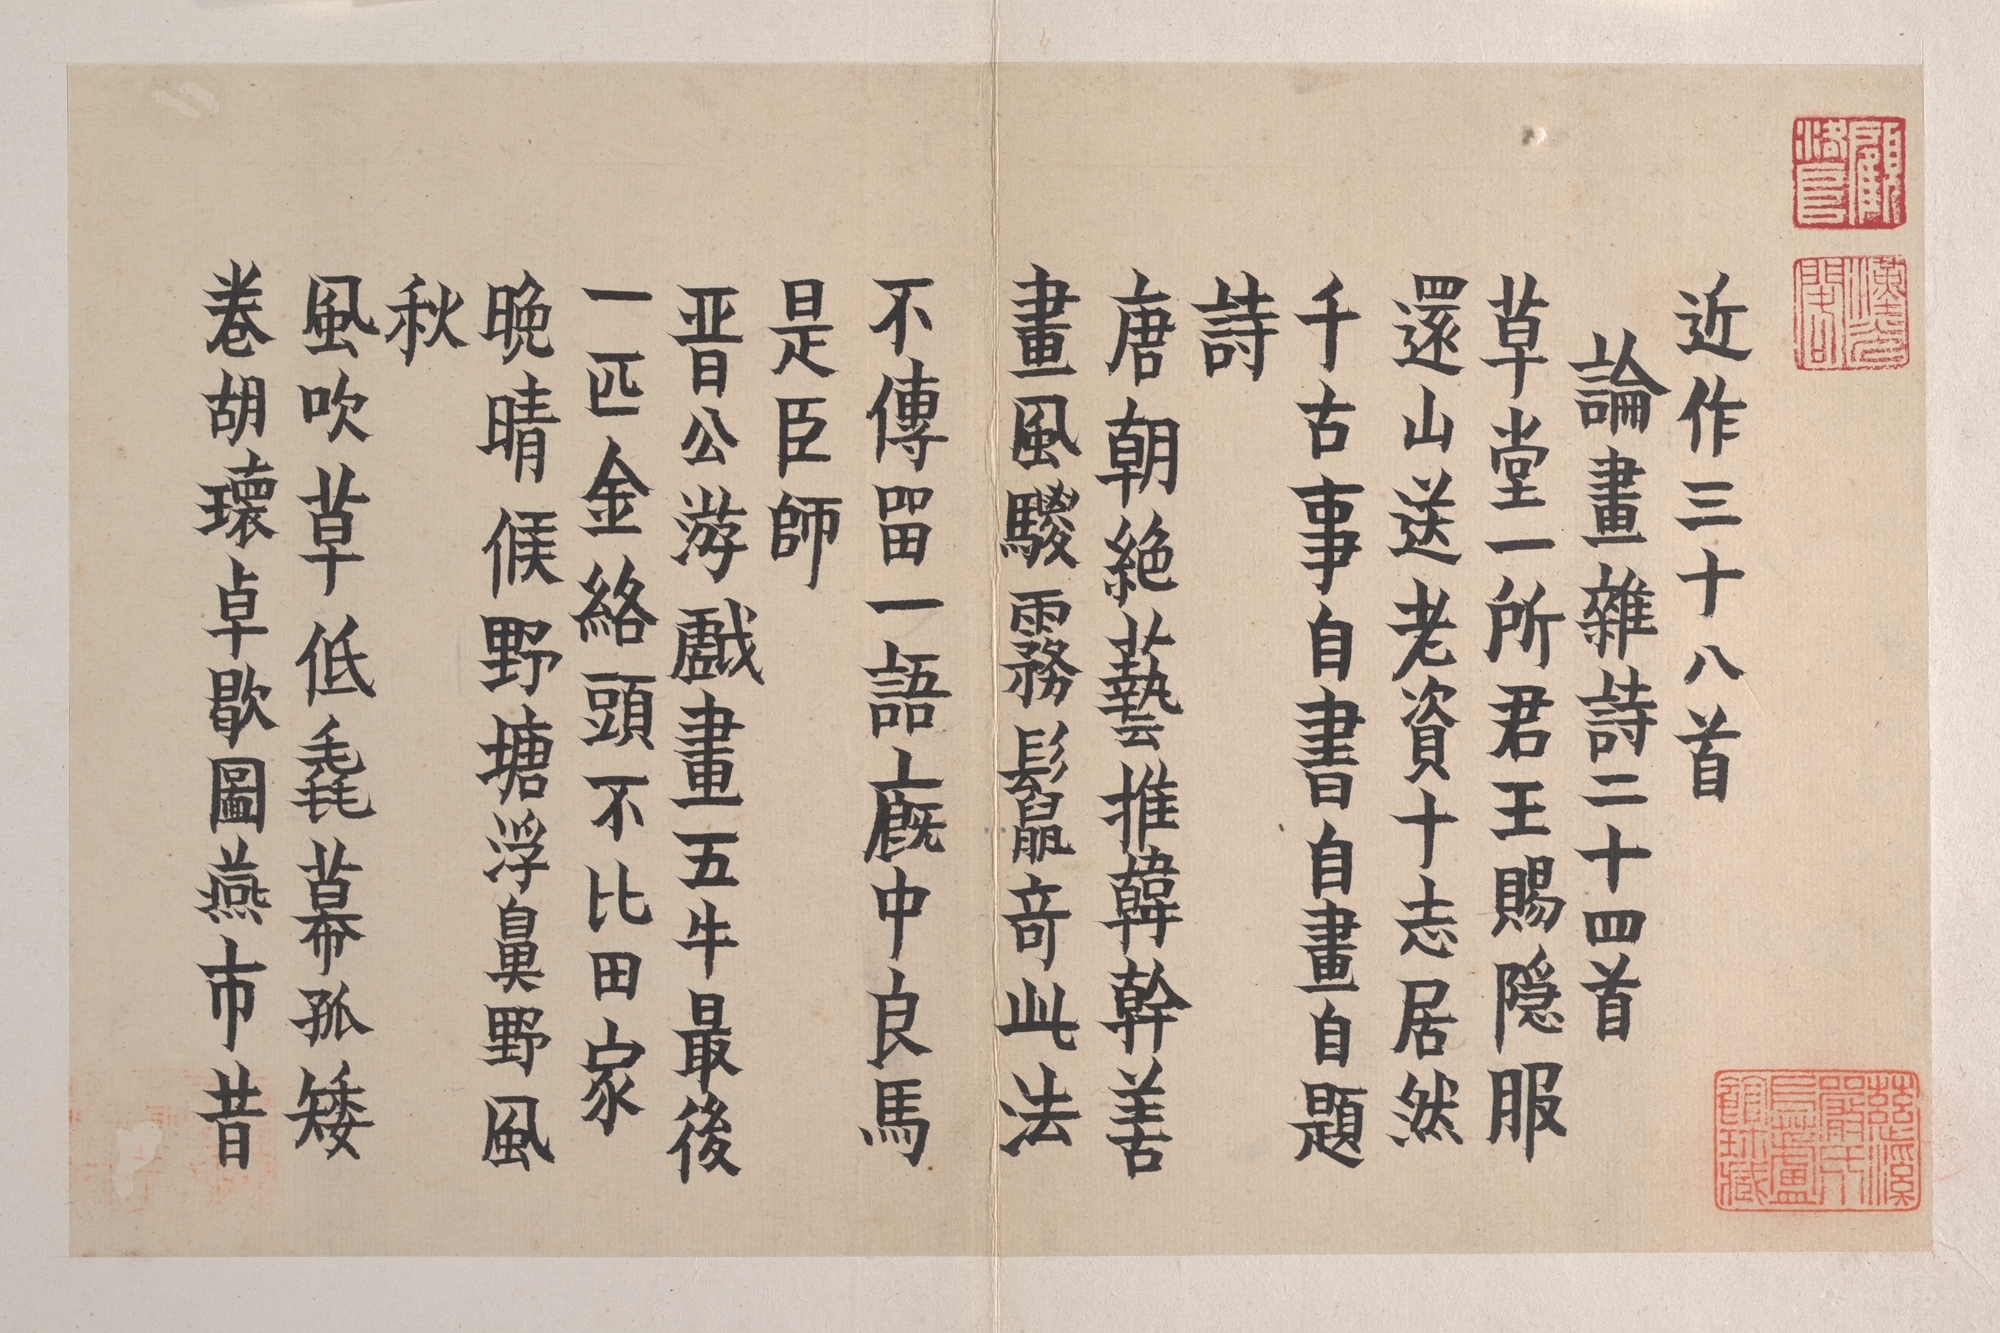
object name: album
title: Poems on Paintings, Written for Ma Yueguan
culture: chinese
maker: jin nong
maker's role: artist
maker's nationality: chinese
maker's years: 1687-1773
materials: ink, paper